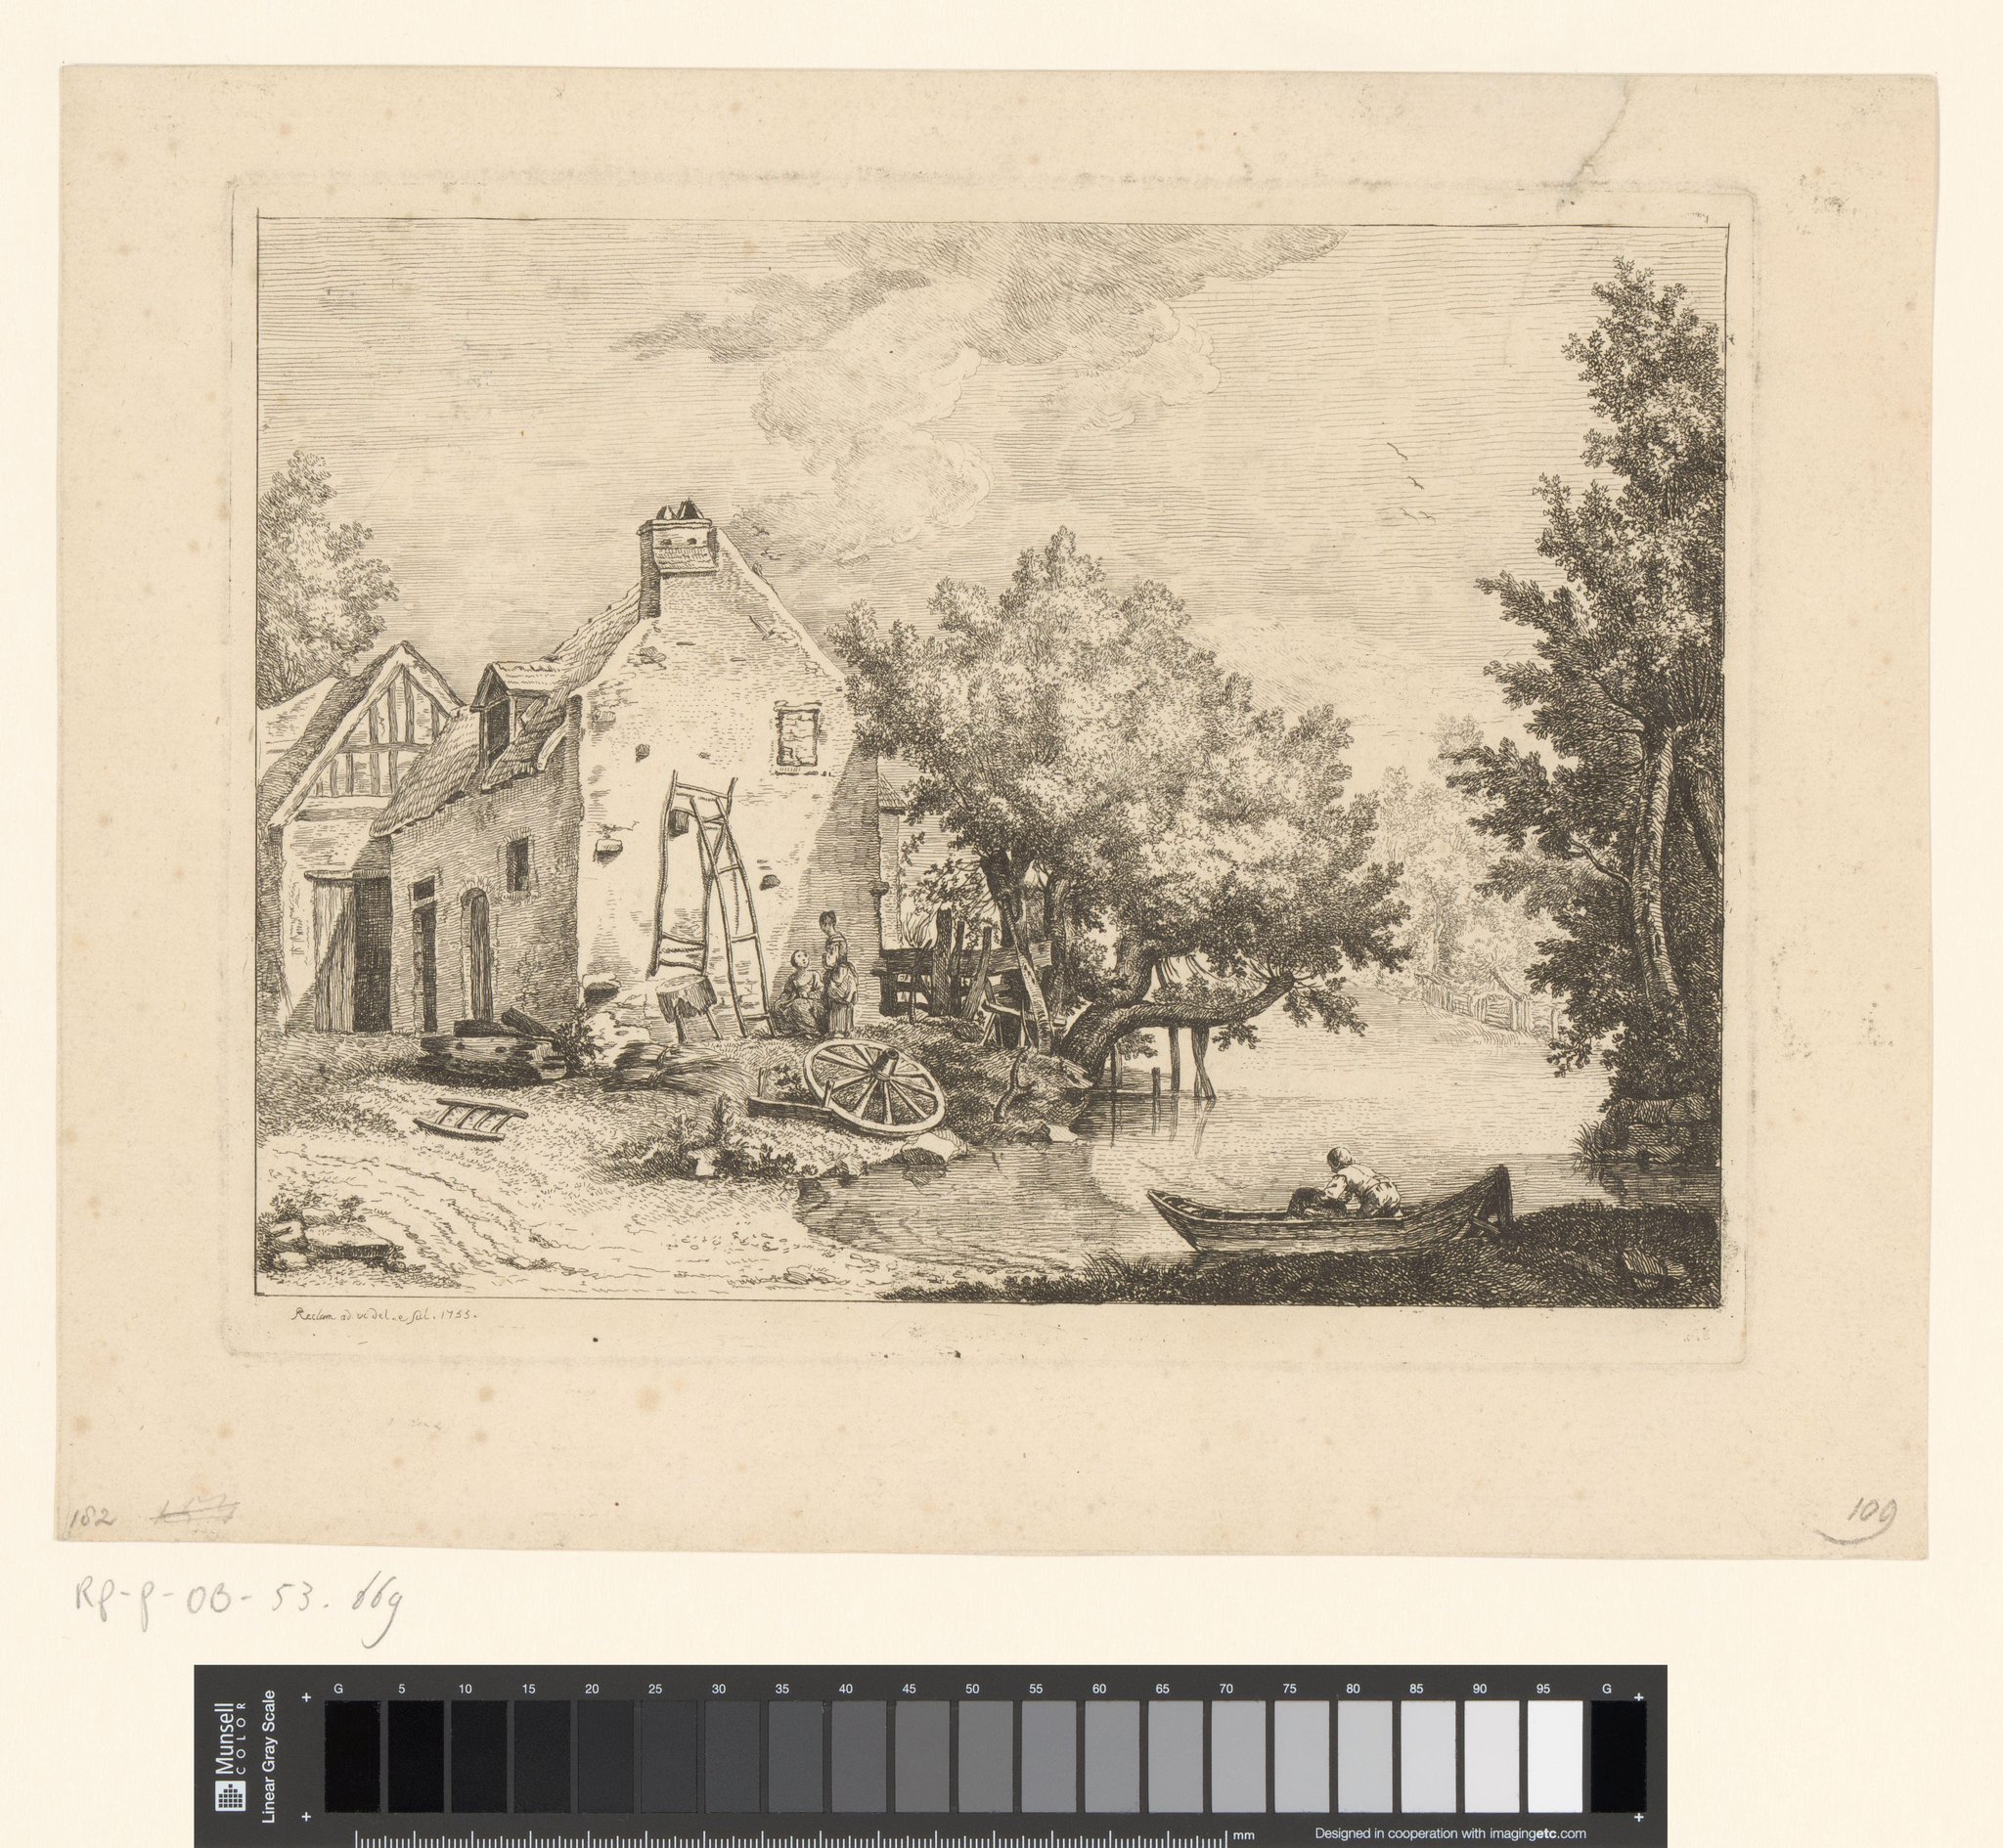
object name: print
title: Gezicht op een huis aan het water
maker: friedrich reclam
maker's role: painter, print maker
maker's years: 1734-1774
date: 1755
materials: paper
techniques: etching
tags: landscapes with waters, waterscapes, seascapes (in the temperate zone), rural housing, e.g. country-house, villa, cottage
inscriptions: collector's mark: Lugt 240